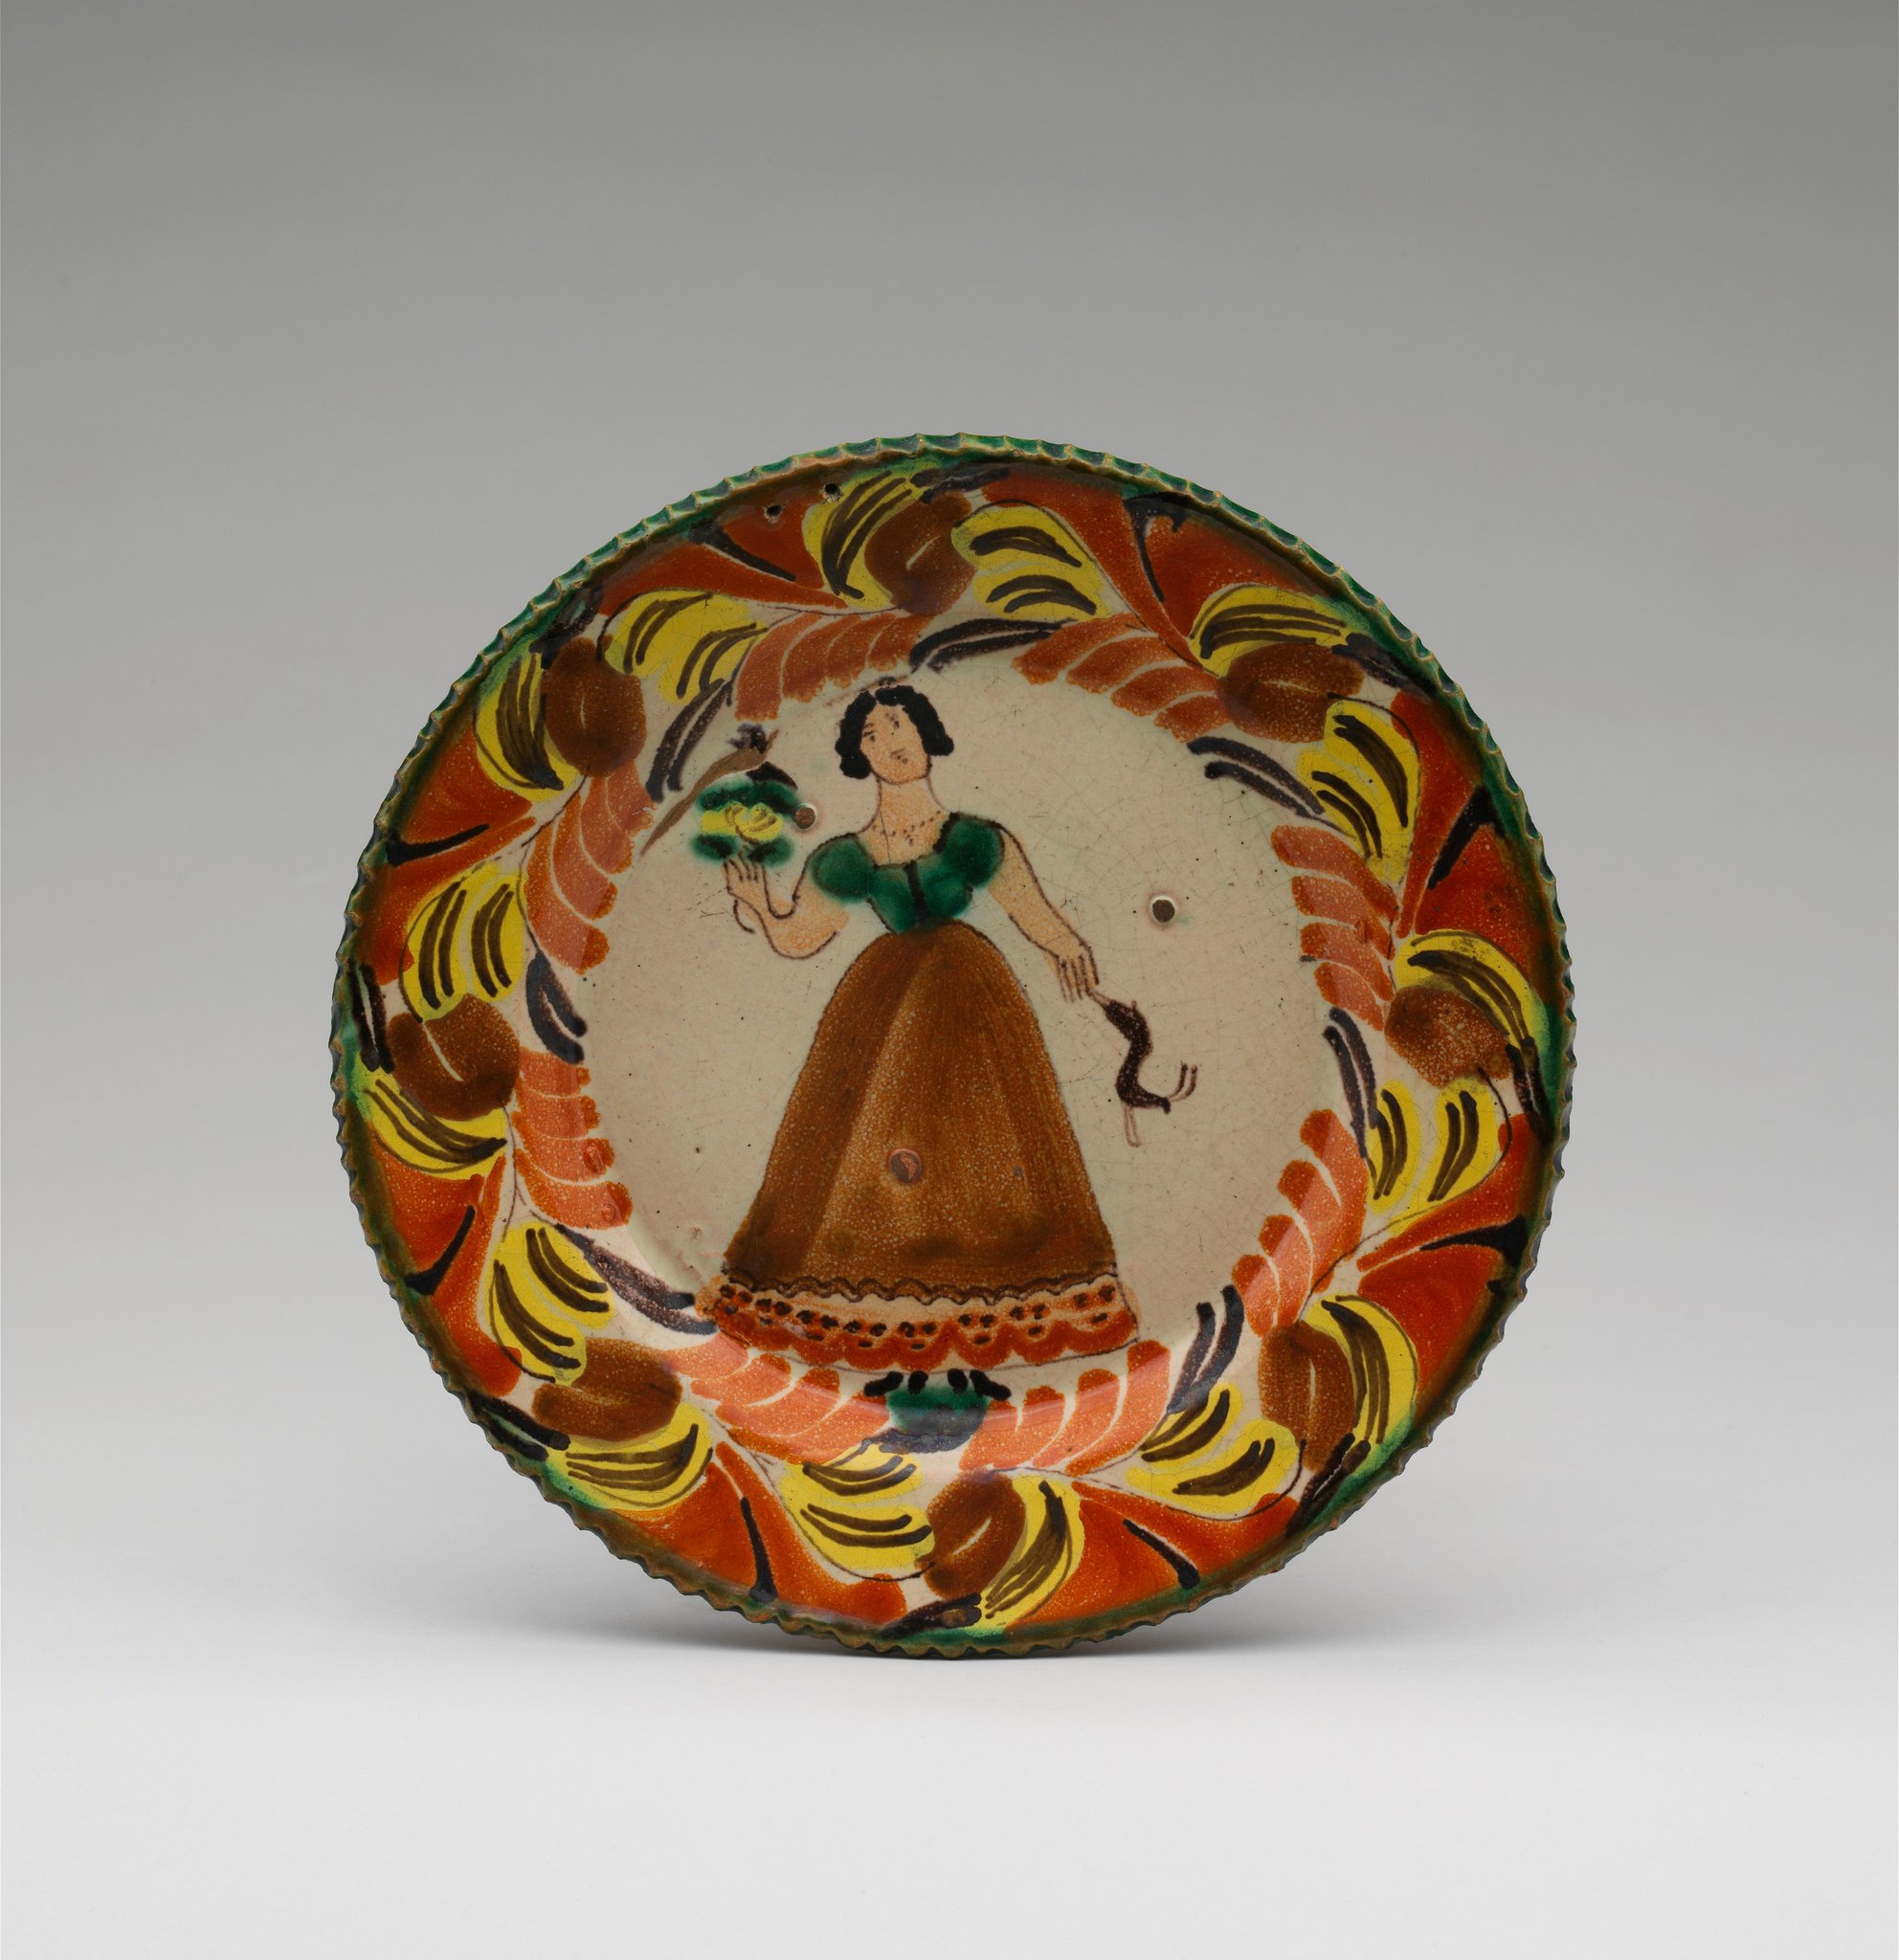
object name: plate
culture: mexican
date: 1800-1900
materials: earthenware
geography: mexico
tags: women